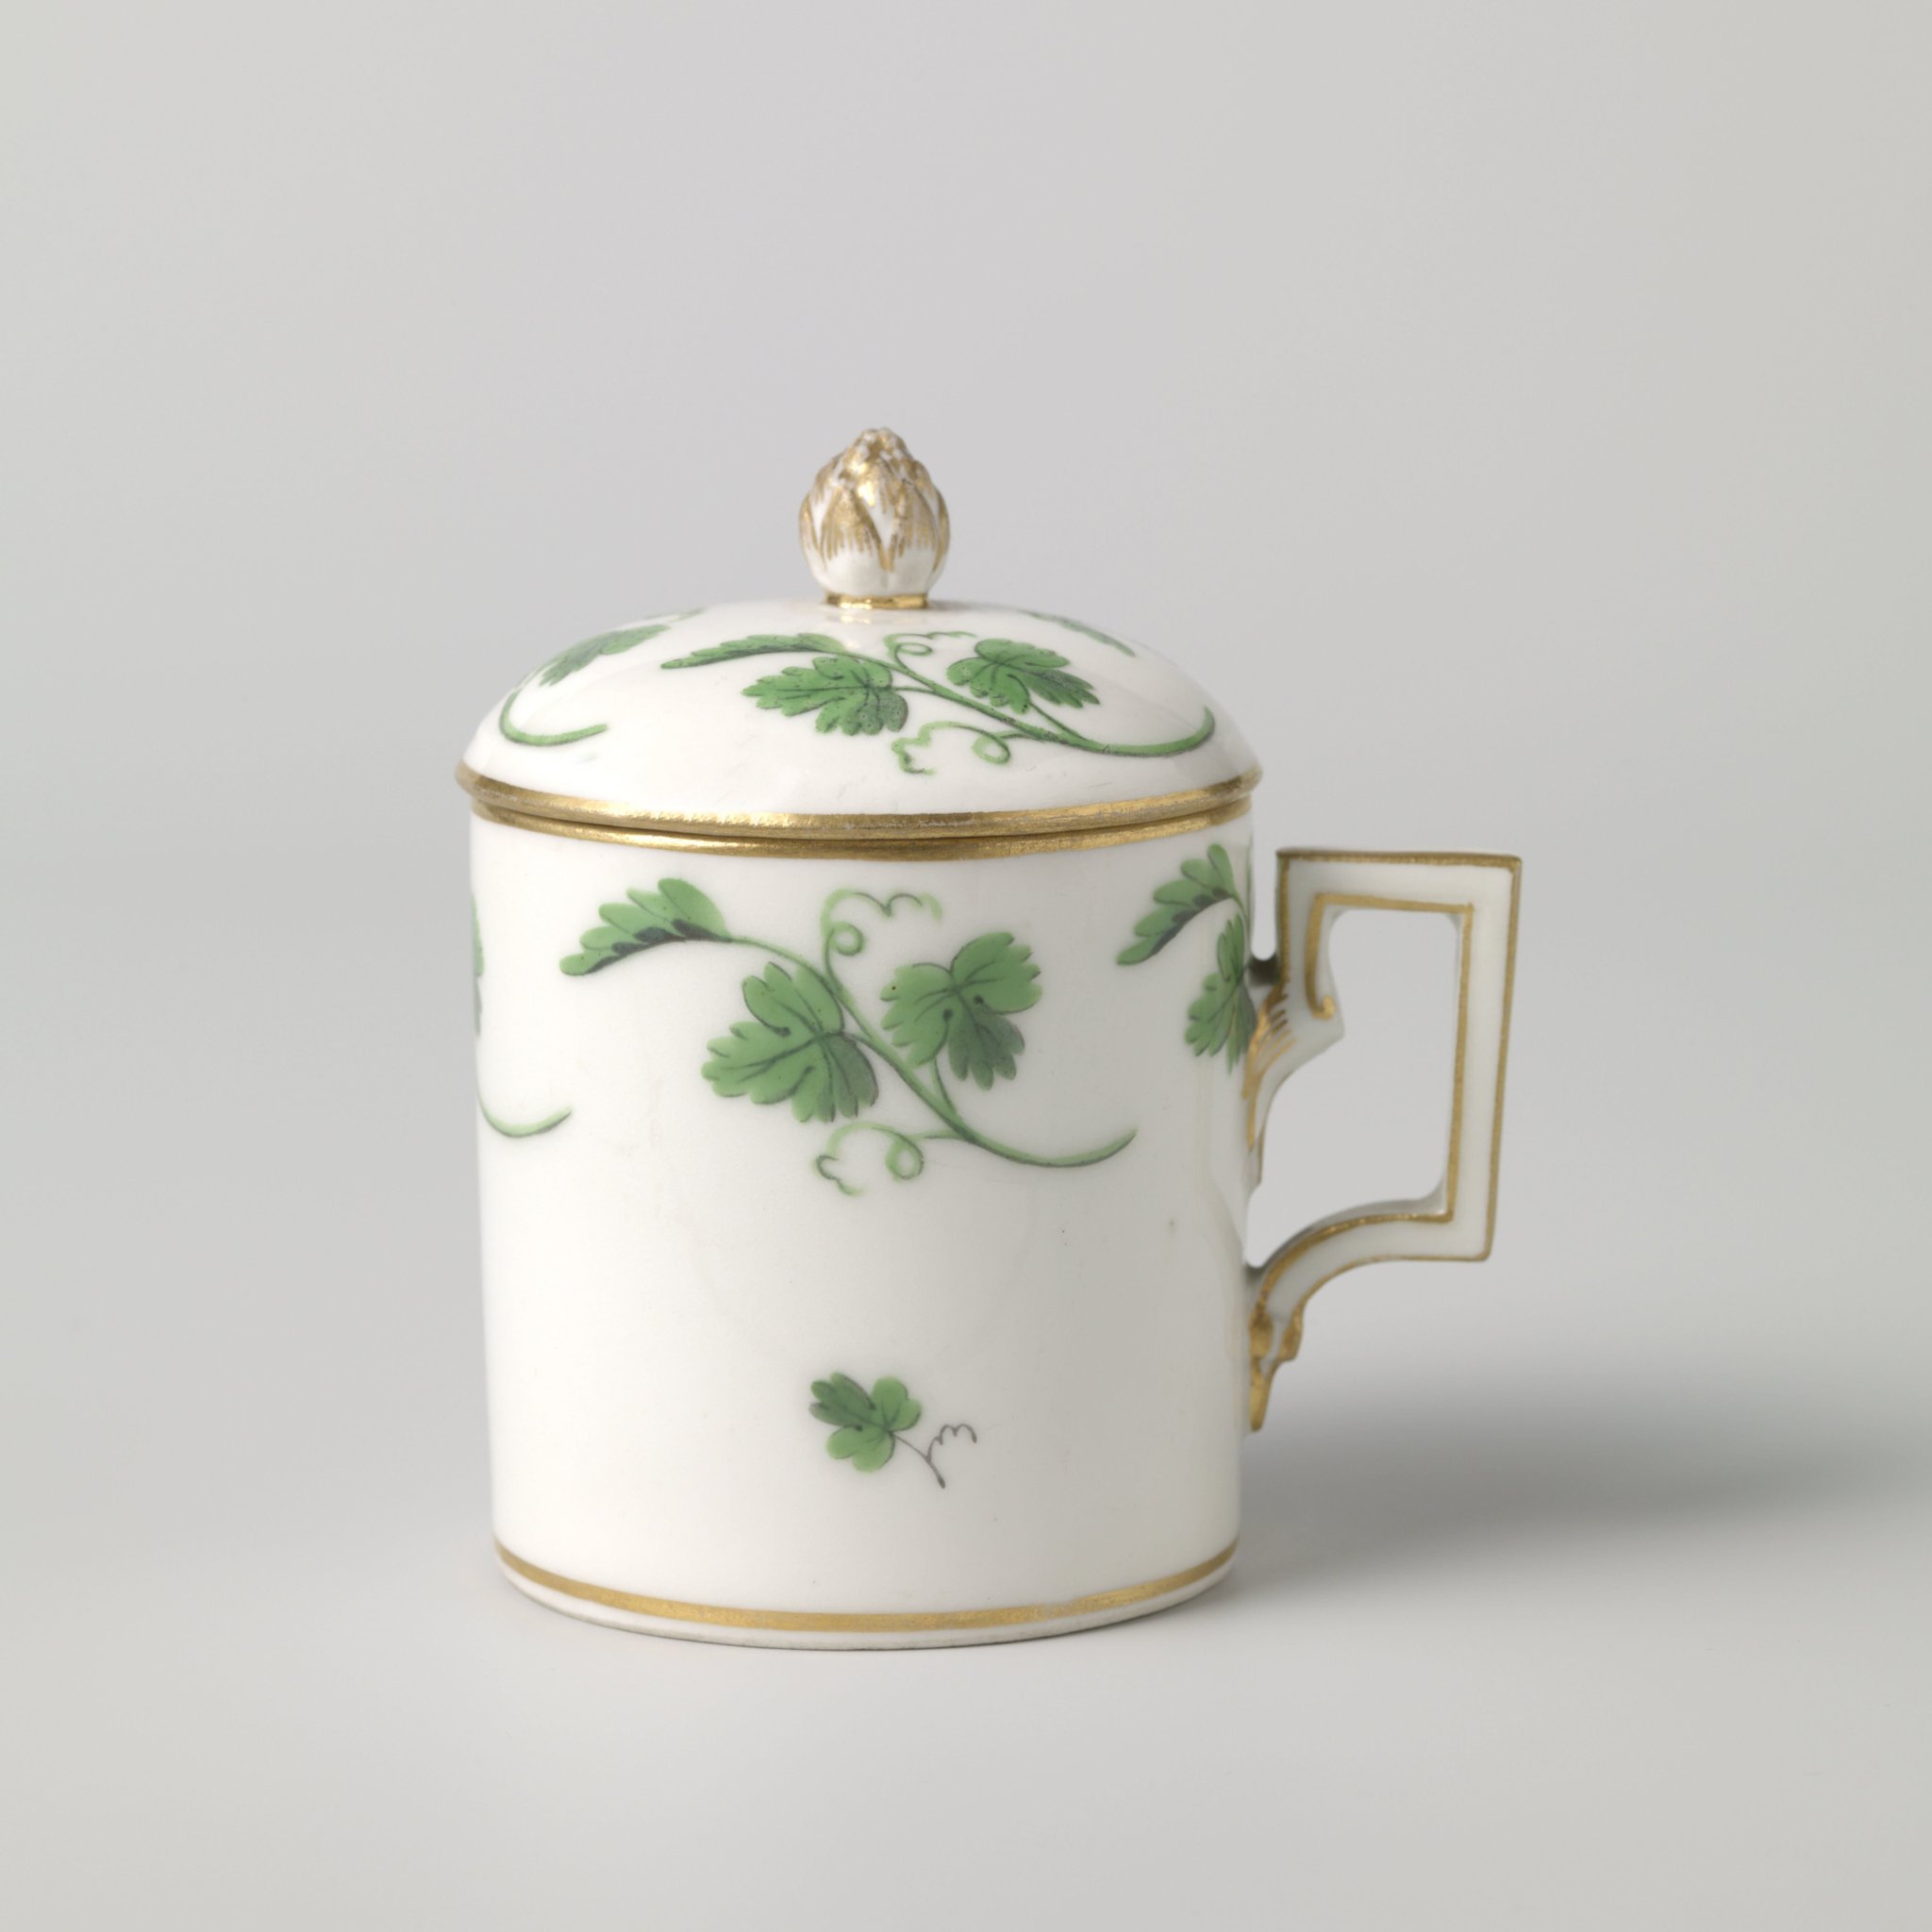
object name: covered cup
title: Covered cup with grapevines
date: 1800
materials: glaze, gold, paint, porcelain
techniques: firing, forming, gilding, turning, vitrification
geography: vienna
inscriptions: mark: ‘schild’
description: Kop van porselein met een cilindrisch lichaam en hoekig oor, beschilderd op het glazuur in groen, zwart en goud. De kop en de deksel zijn versierd met wijnranken. Dekselknop in de vorm van een bloemknop. Gemerkt op de onderzijde met het schild.